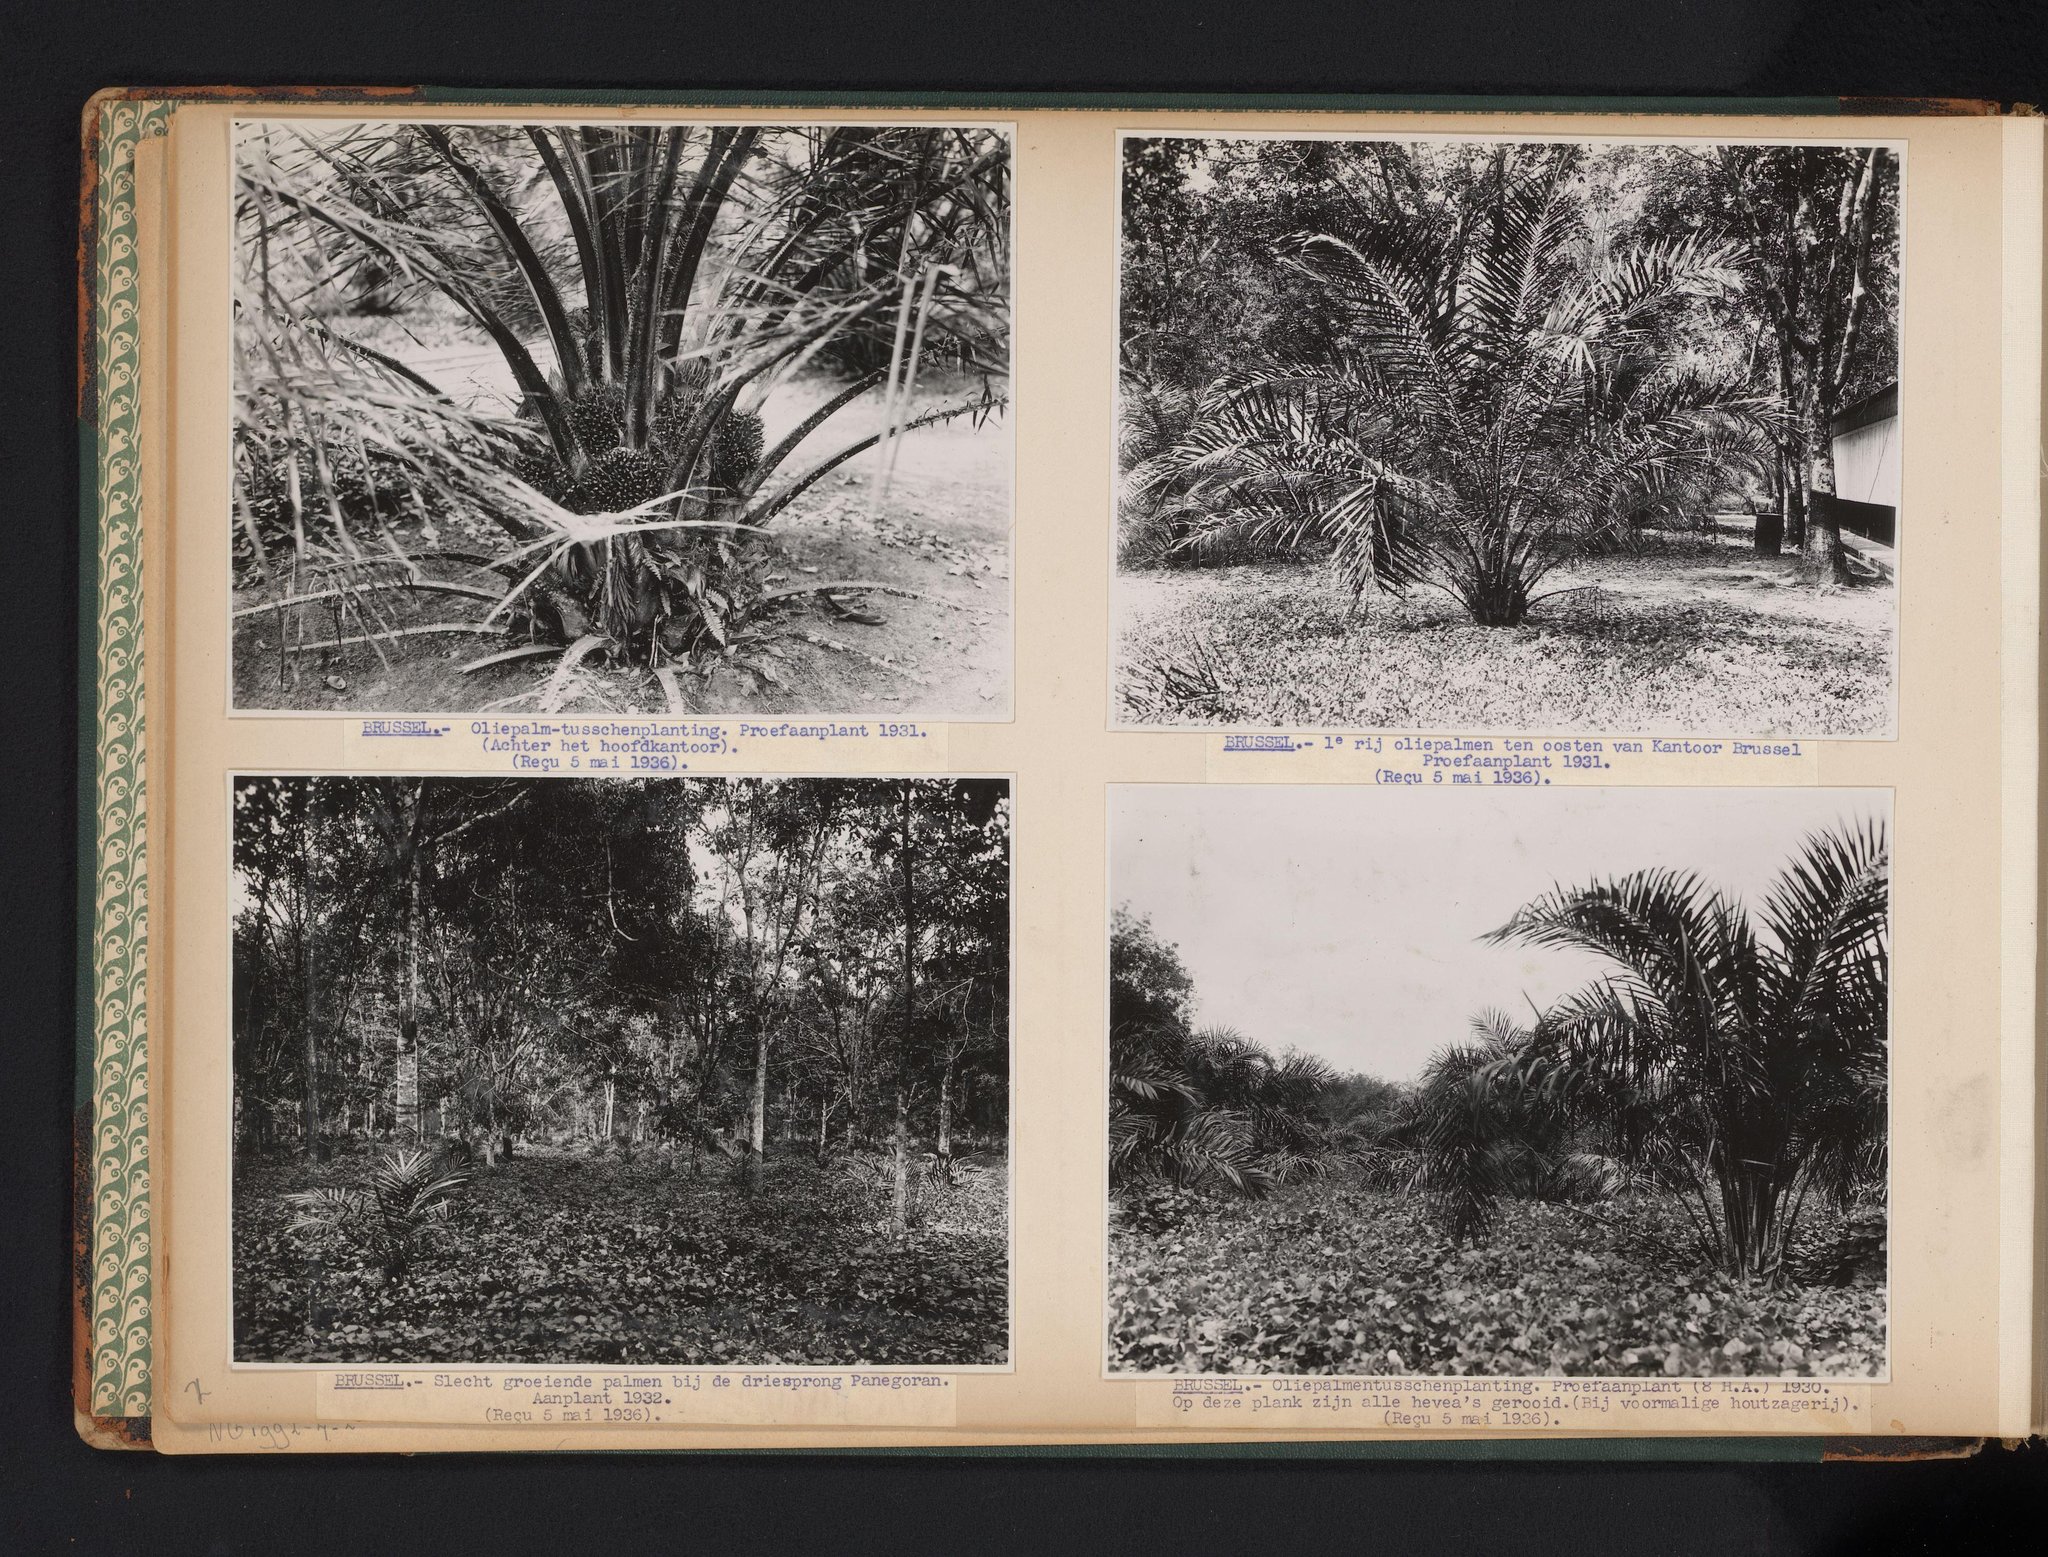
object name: photograph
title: Oliepalmen op Brussel, 1936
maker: Anonymous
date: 1936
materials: cardboard, photographic support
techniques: gelatin silver print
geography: sumatra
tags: plantation, (non-fruit) products of plants or trees: palm oil, sumatra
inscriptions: inscription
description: Blad met vier foto's van oliepalmen op Brussel, 1936. Met etiketten met onderschriften onder de foto's. Onderdeel van het fotoalbum over de plantages Pernantian en Brussel van de Sumatra Caoutchouc Maatschappij op de Oostkust van Sumatra in de jaren 1935-1939.